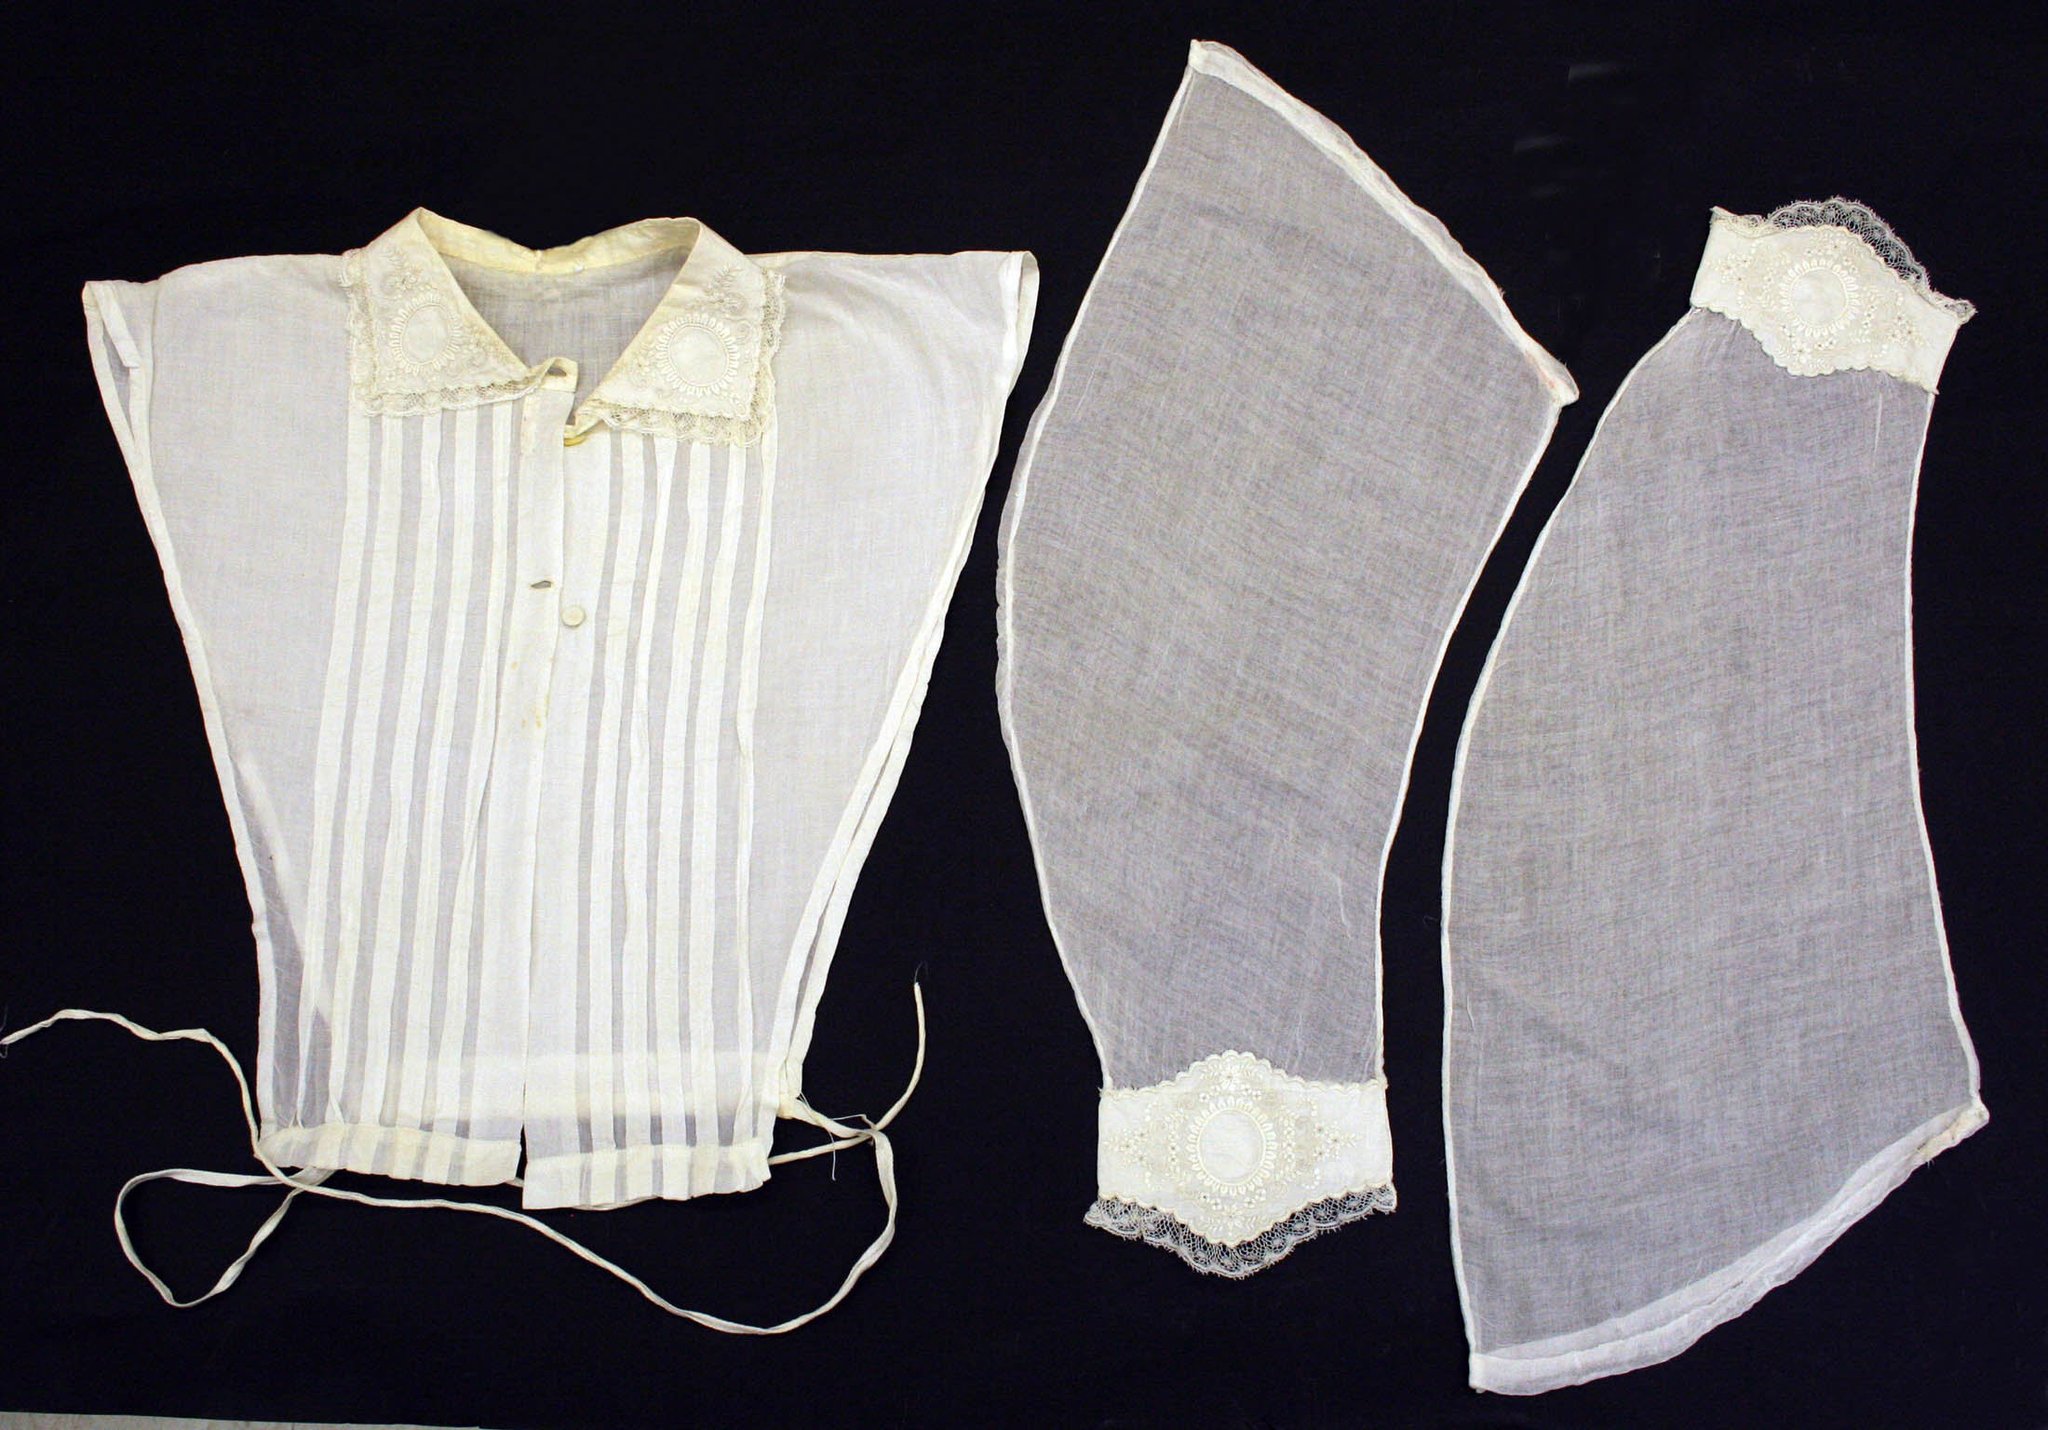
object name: accessory set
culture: french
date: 1850-1869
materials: cotton